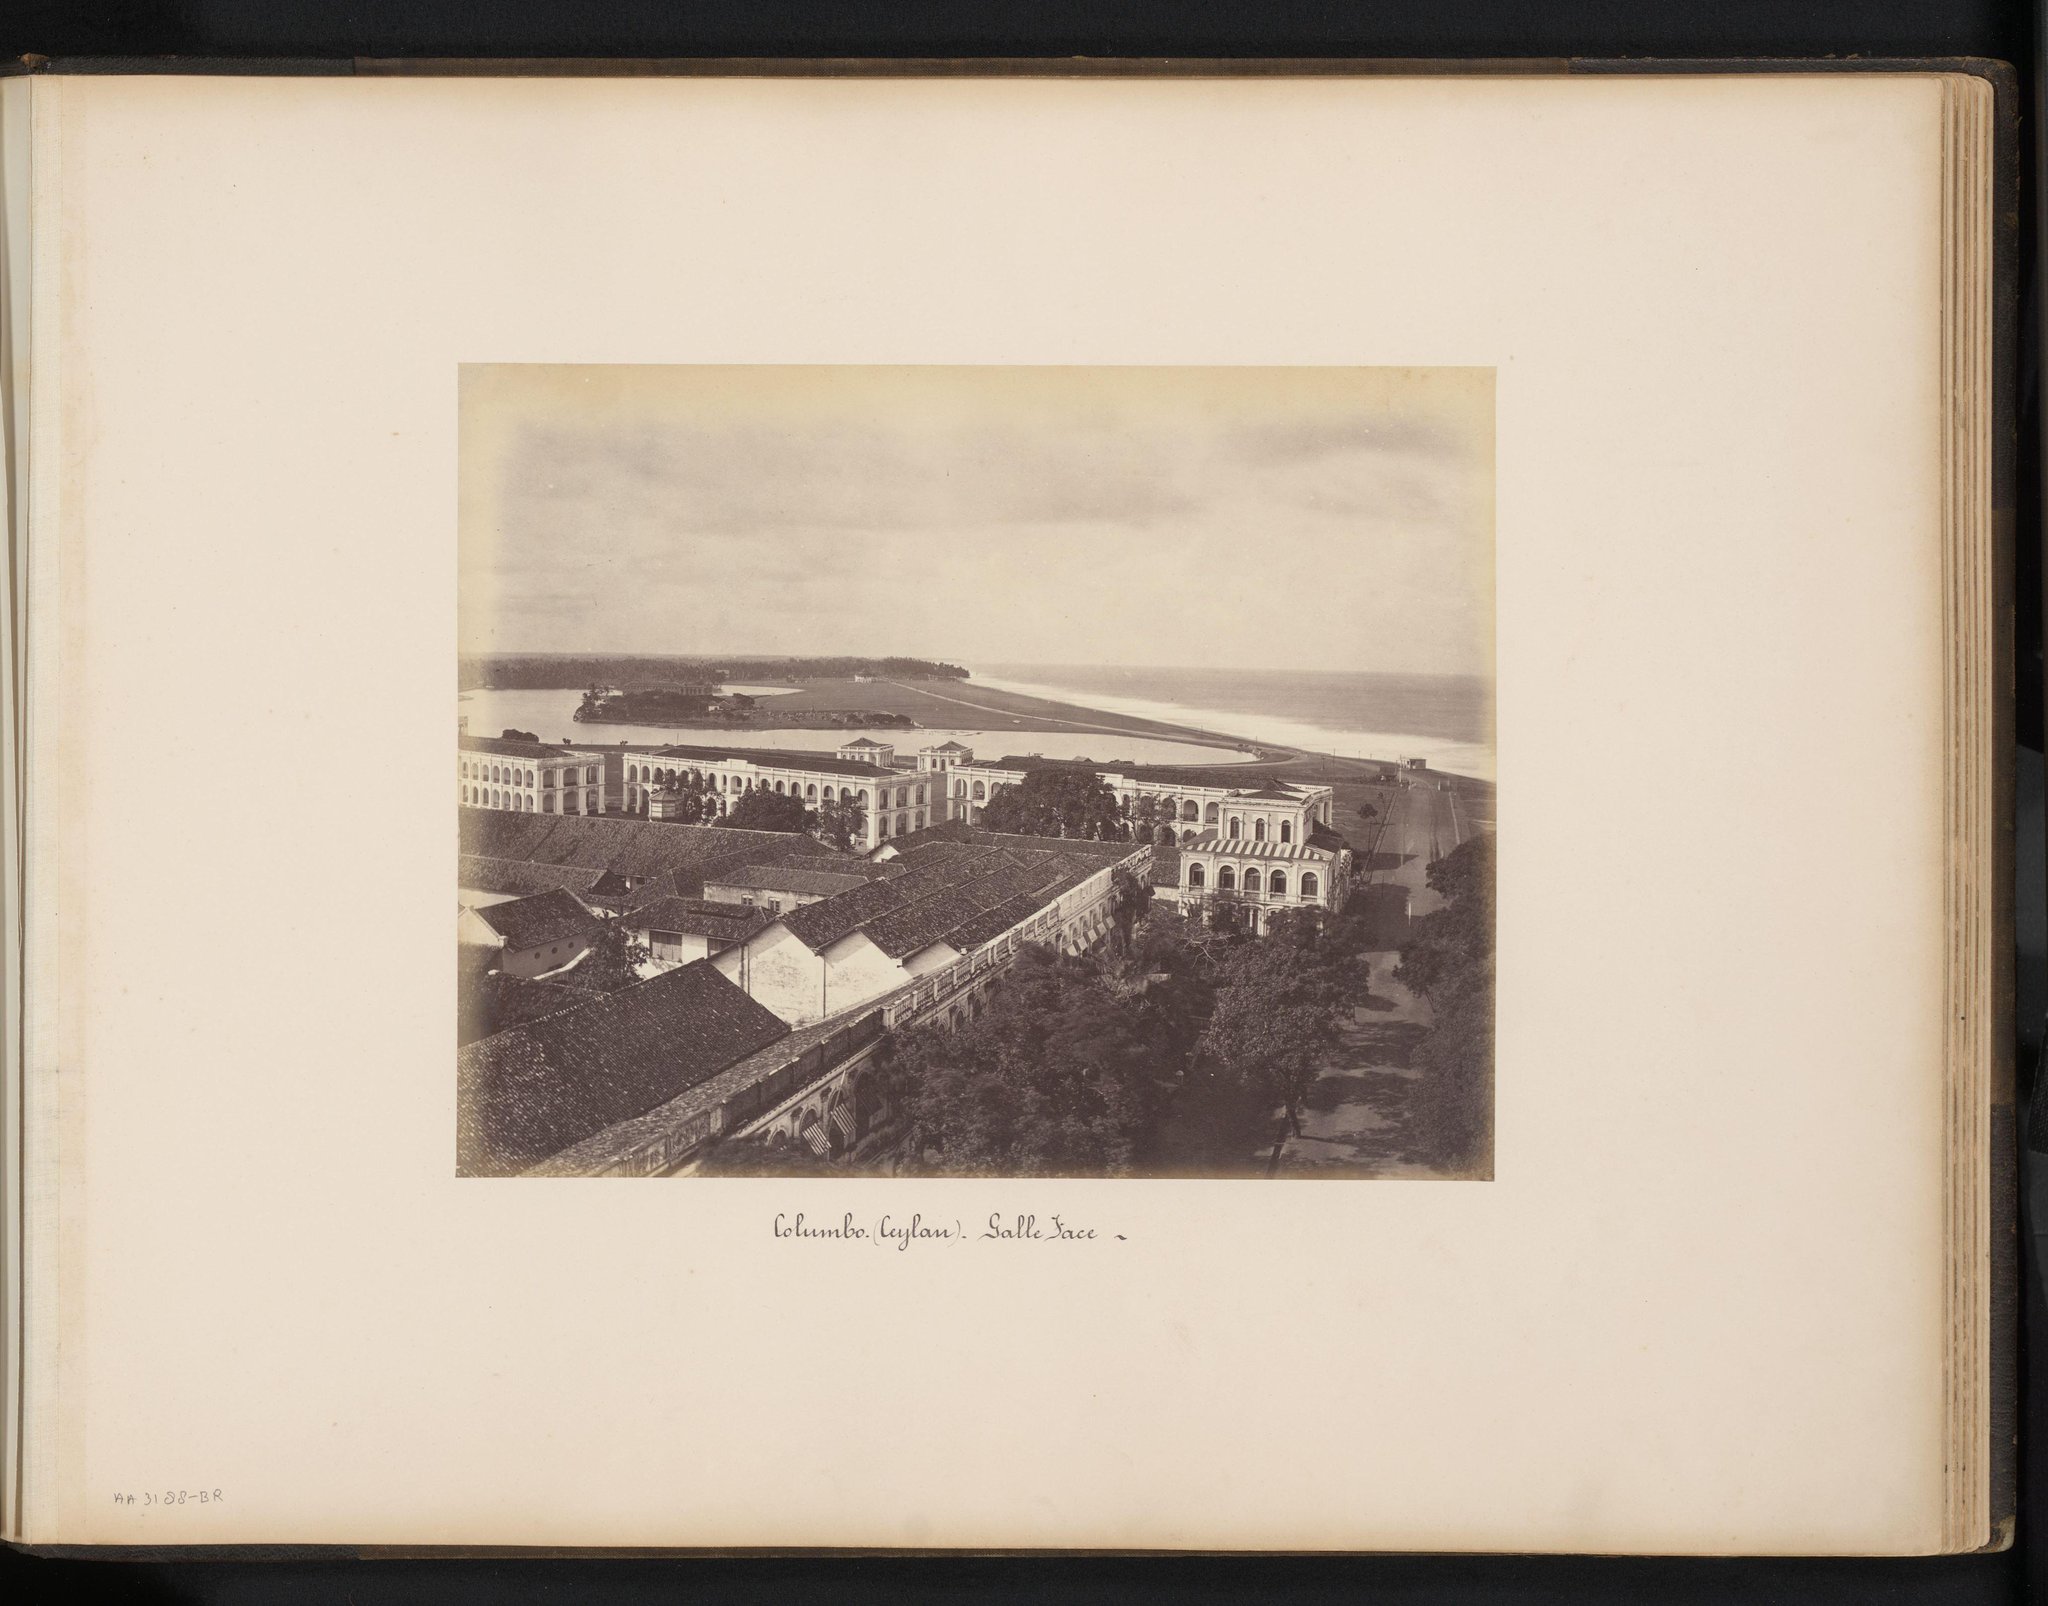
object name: photograph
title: View of the Galle Face, Colombo, Sri Lanka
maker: Anonymous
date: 1880-1883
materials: photographic support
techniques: albumen print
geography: colombo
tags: public gardens, park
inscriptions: title: ‘Columbo. (Ceylan) _ Galle Face _’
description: Onderdeel van Reisalbum met opnames van bezienswaardigheden in Egypte, Nederlands-Indië, Singapore en Ceylon.